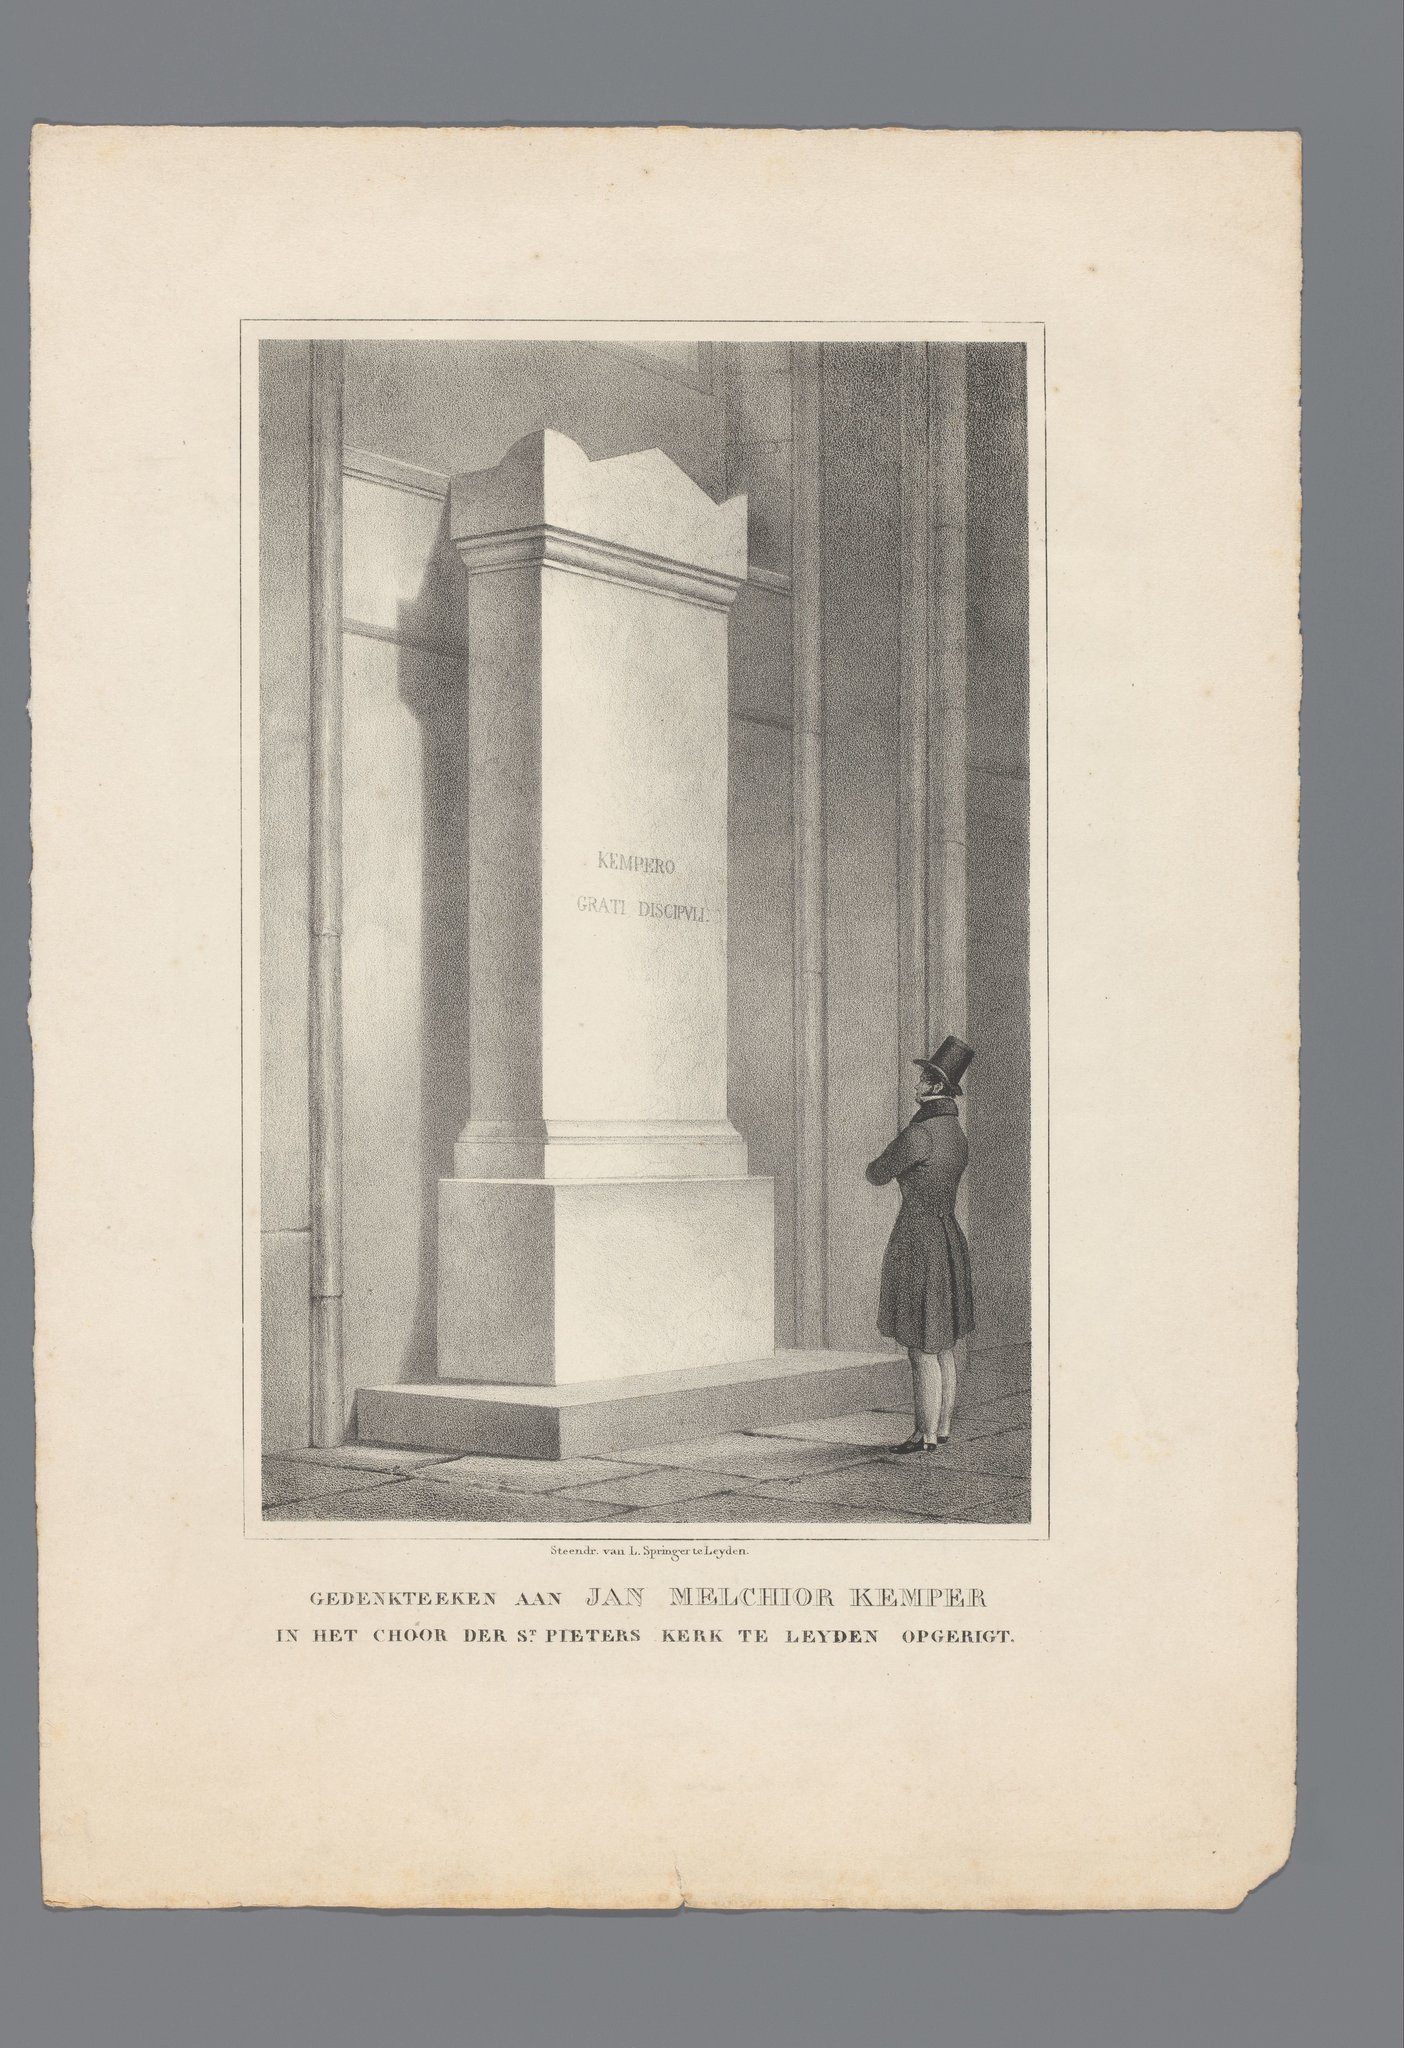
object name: print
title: Gedenkteken voor J.M. Kemper in de Pieterskerk te Leiden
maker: leendert springer (i)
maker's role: draughtsman, painter, print maker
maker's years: 1789-1871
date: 1835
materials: paper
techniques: lithograph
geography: leiden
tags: amsterdam, jonkheer joan melchior kemper, grave-building, monumental tomb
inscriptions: collector's mark: Lugt 2228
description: Gedenkteken voor de Leidse professor Jan Melchior Kemper (overleden 20 juli 1824) opgericht in de Pieterskerk te Leiden op 30 mei 1835. Een man staande voor het sobere monument ontworpen door D. Humbert de Superville.